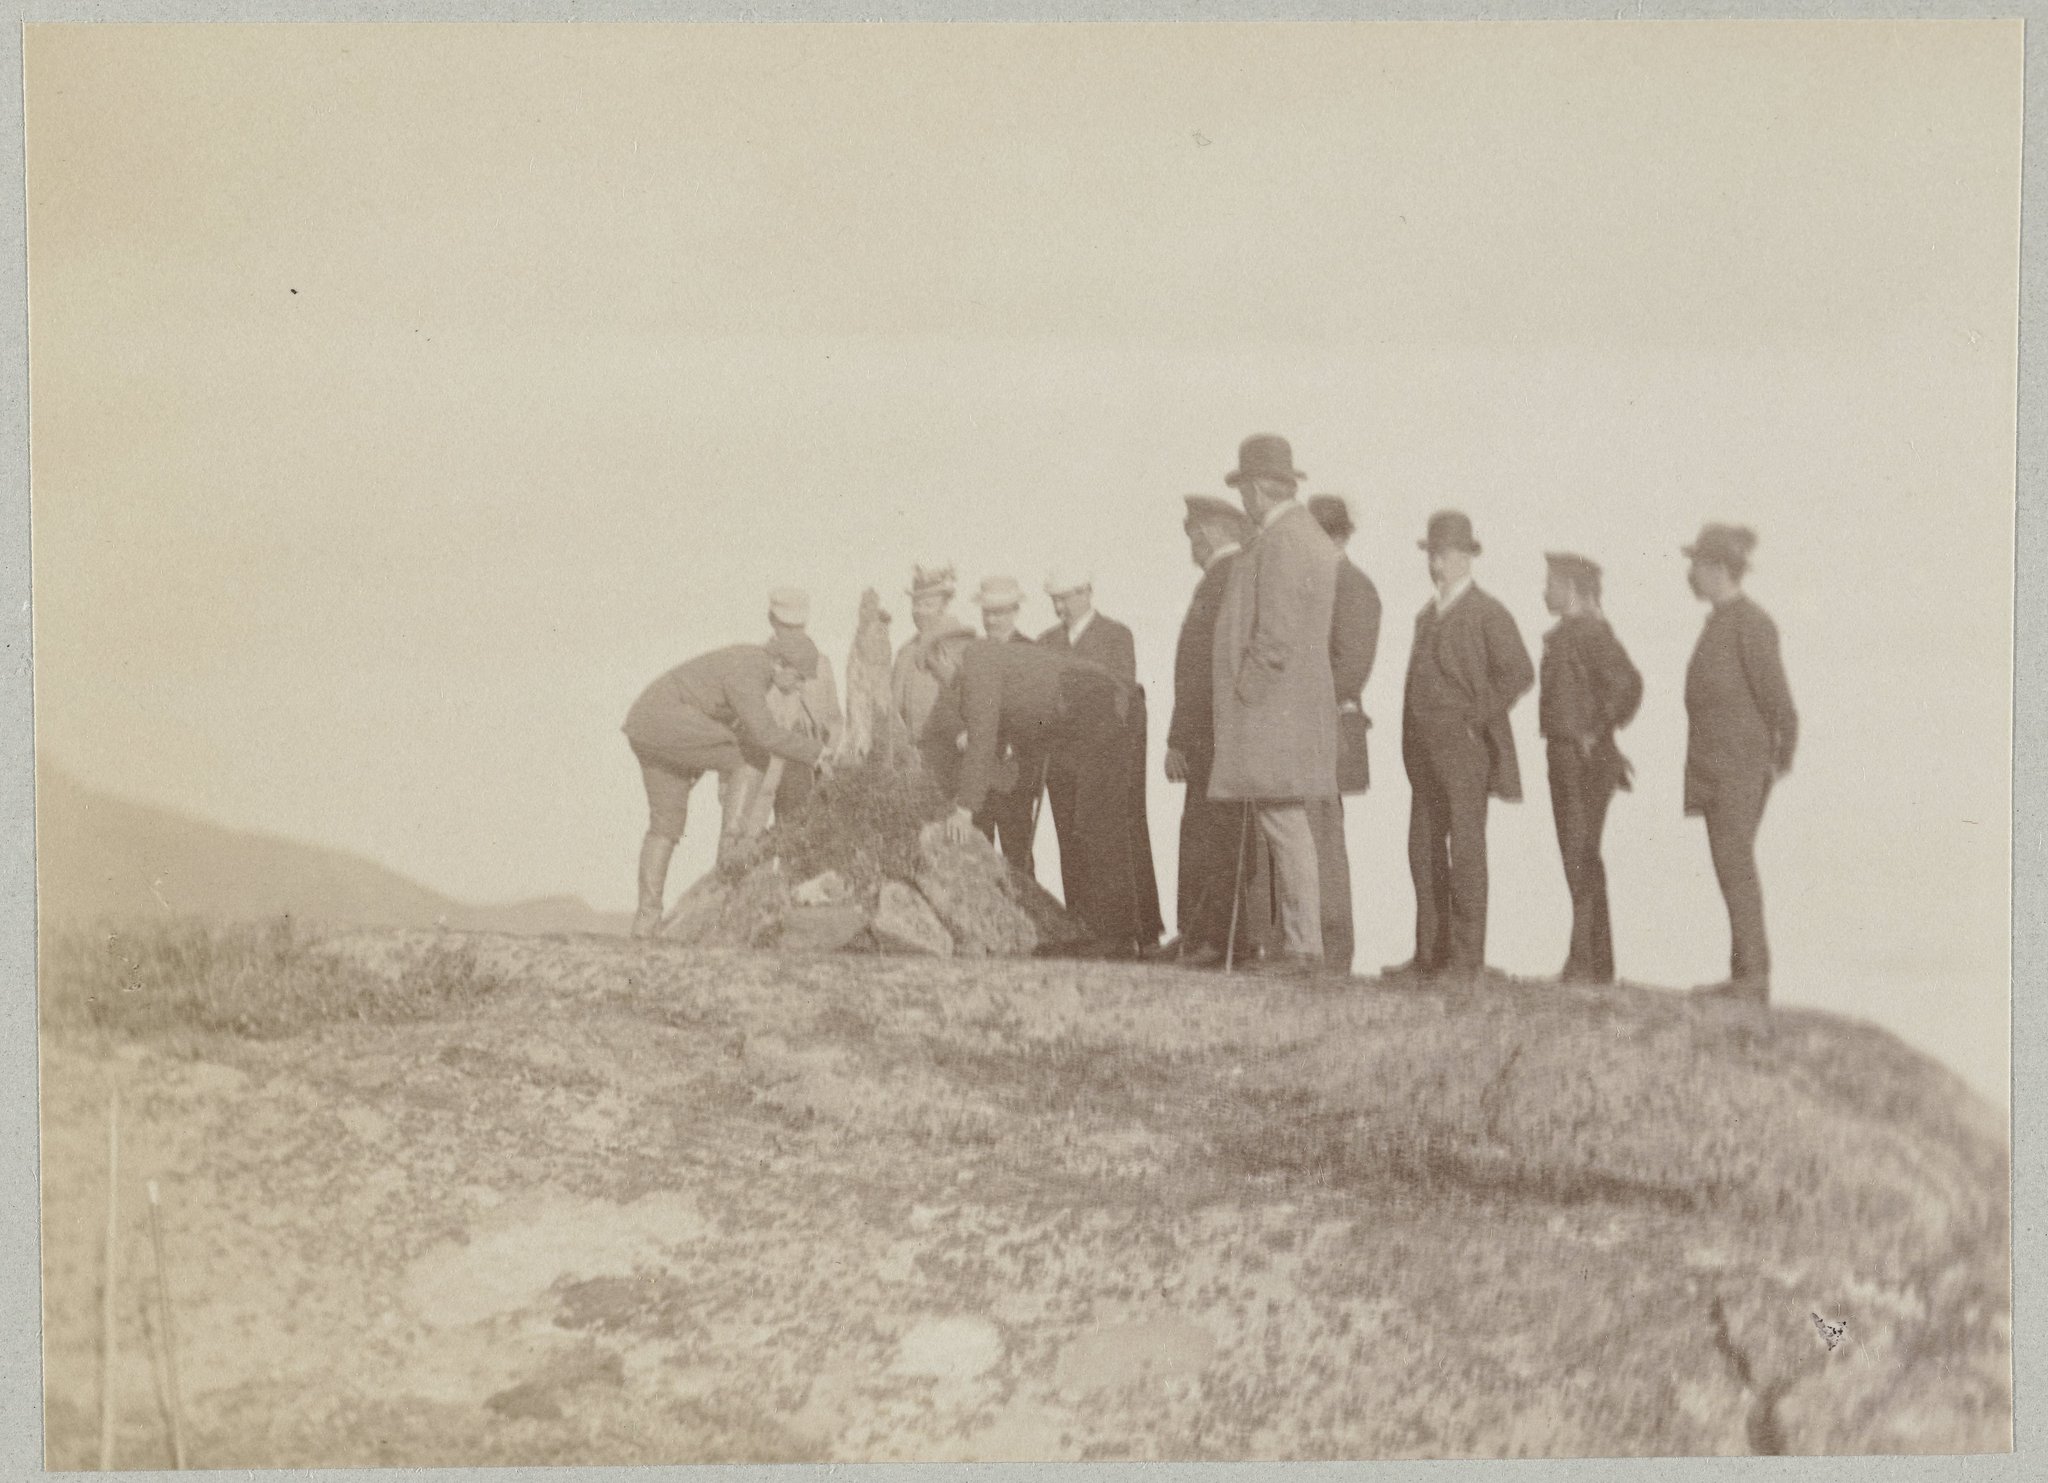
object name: photograph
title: In den Lofoten, Errichtung des Steinmanns auf dem Gipfel von Diggermulen und Heimkehr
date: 1807-1889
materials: cardboard, paper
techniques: albumen print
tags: wilhelm ii (keizer van duitsland), norway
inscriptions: number: ‘33’